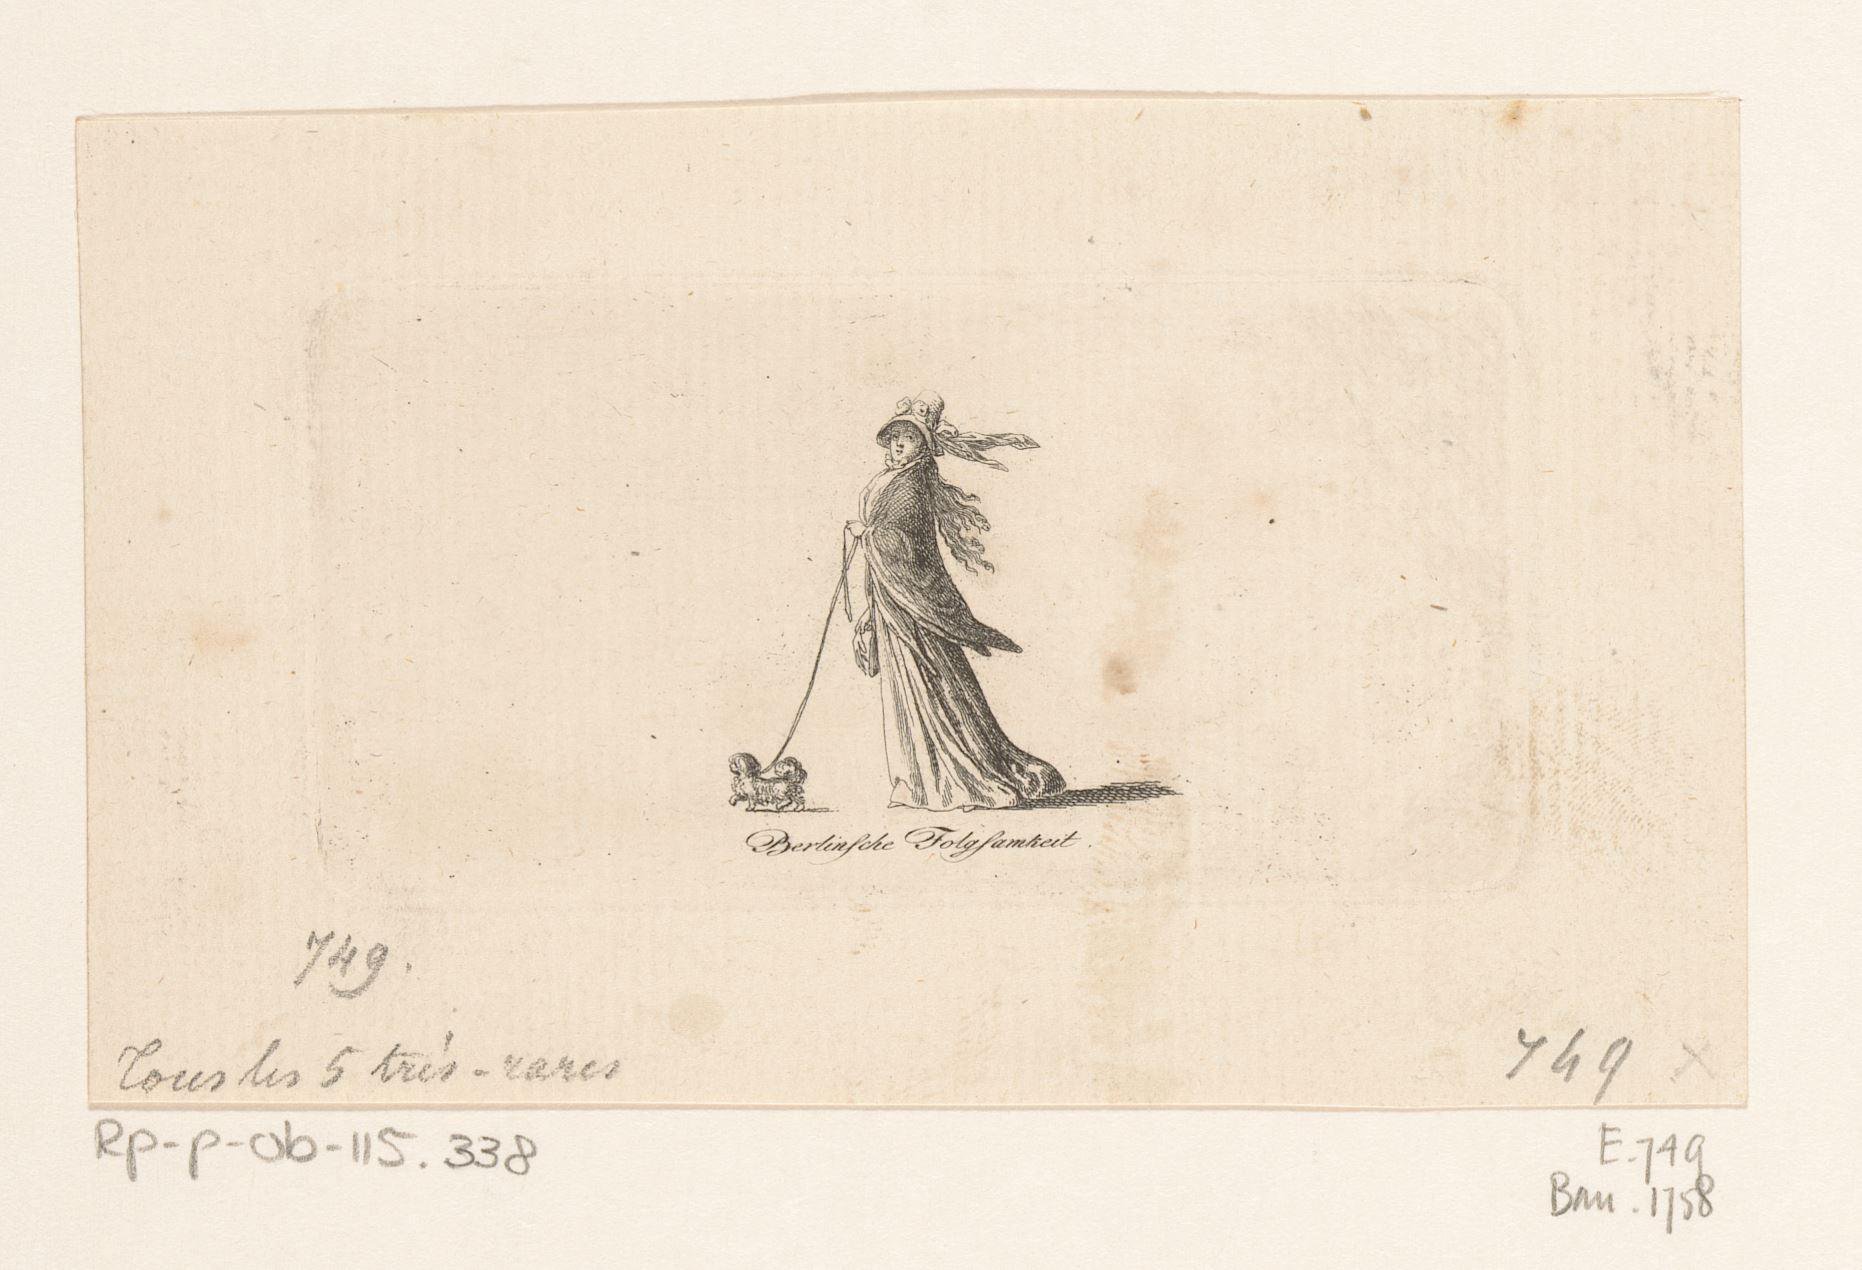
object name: print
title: Vrouw met aangelijnde hond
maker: daniel nikolaus chodowiecki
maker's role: draughtsman, print maker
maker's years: 1726-1801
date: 1794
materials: paper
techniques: etching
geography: berlin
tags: adult woman, walking the dog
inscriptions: collector's mark: Lugt 2228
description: Daniel Chodowiecki maakte deze prent naar aanleiding van de Berlijnse politieverordening dat honden aangelijnd moesten zijn bij het uitlaten.